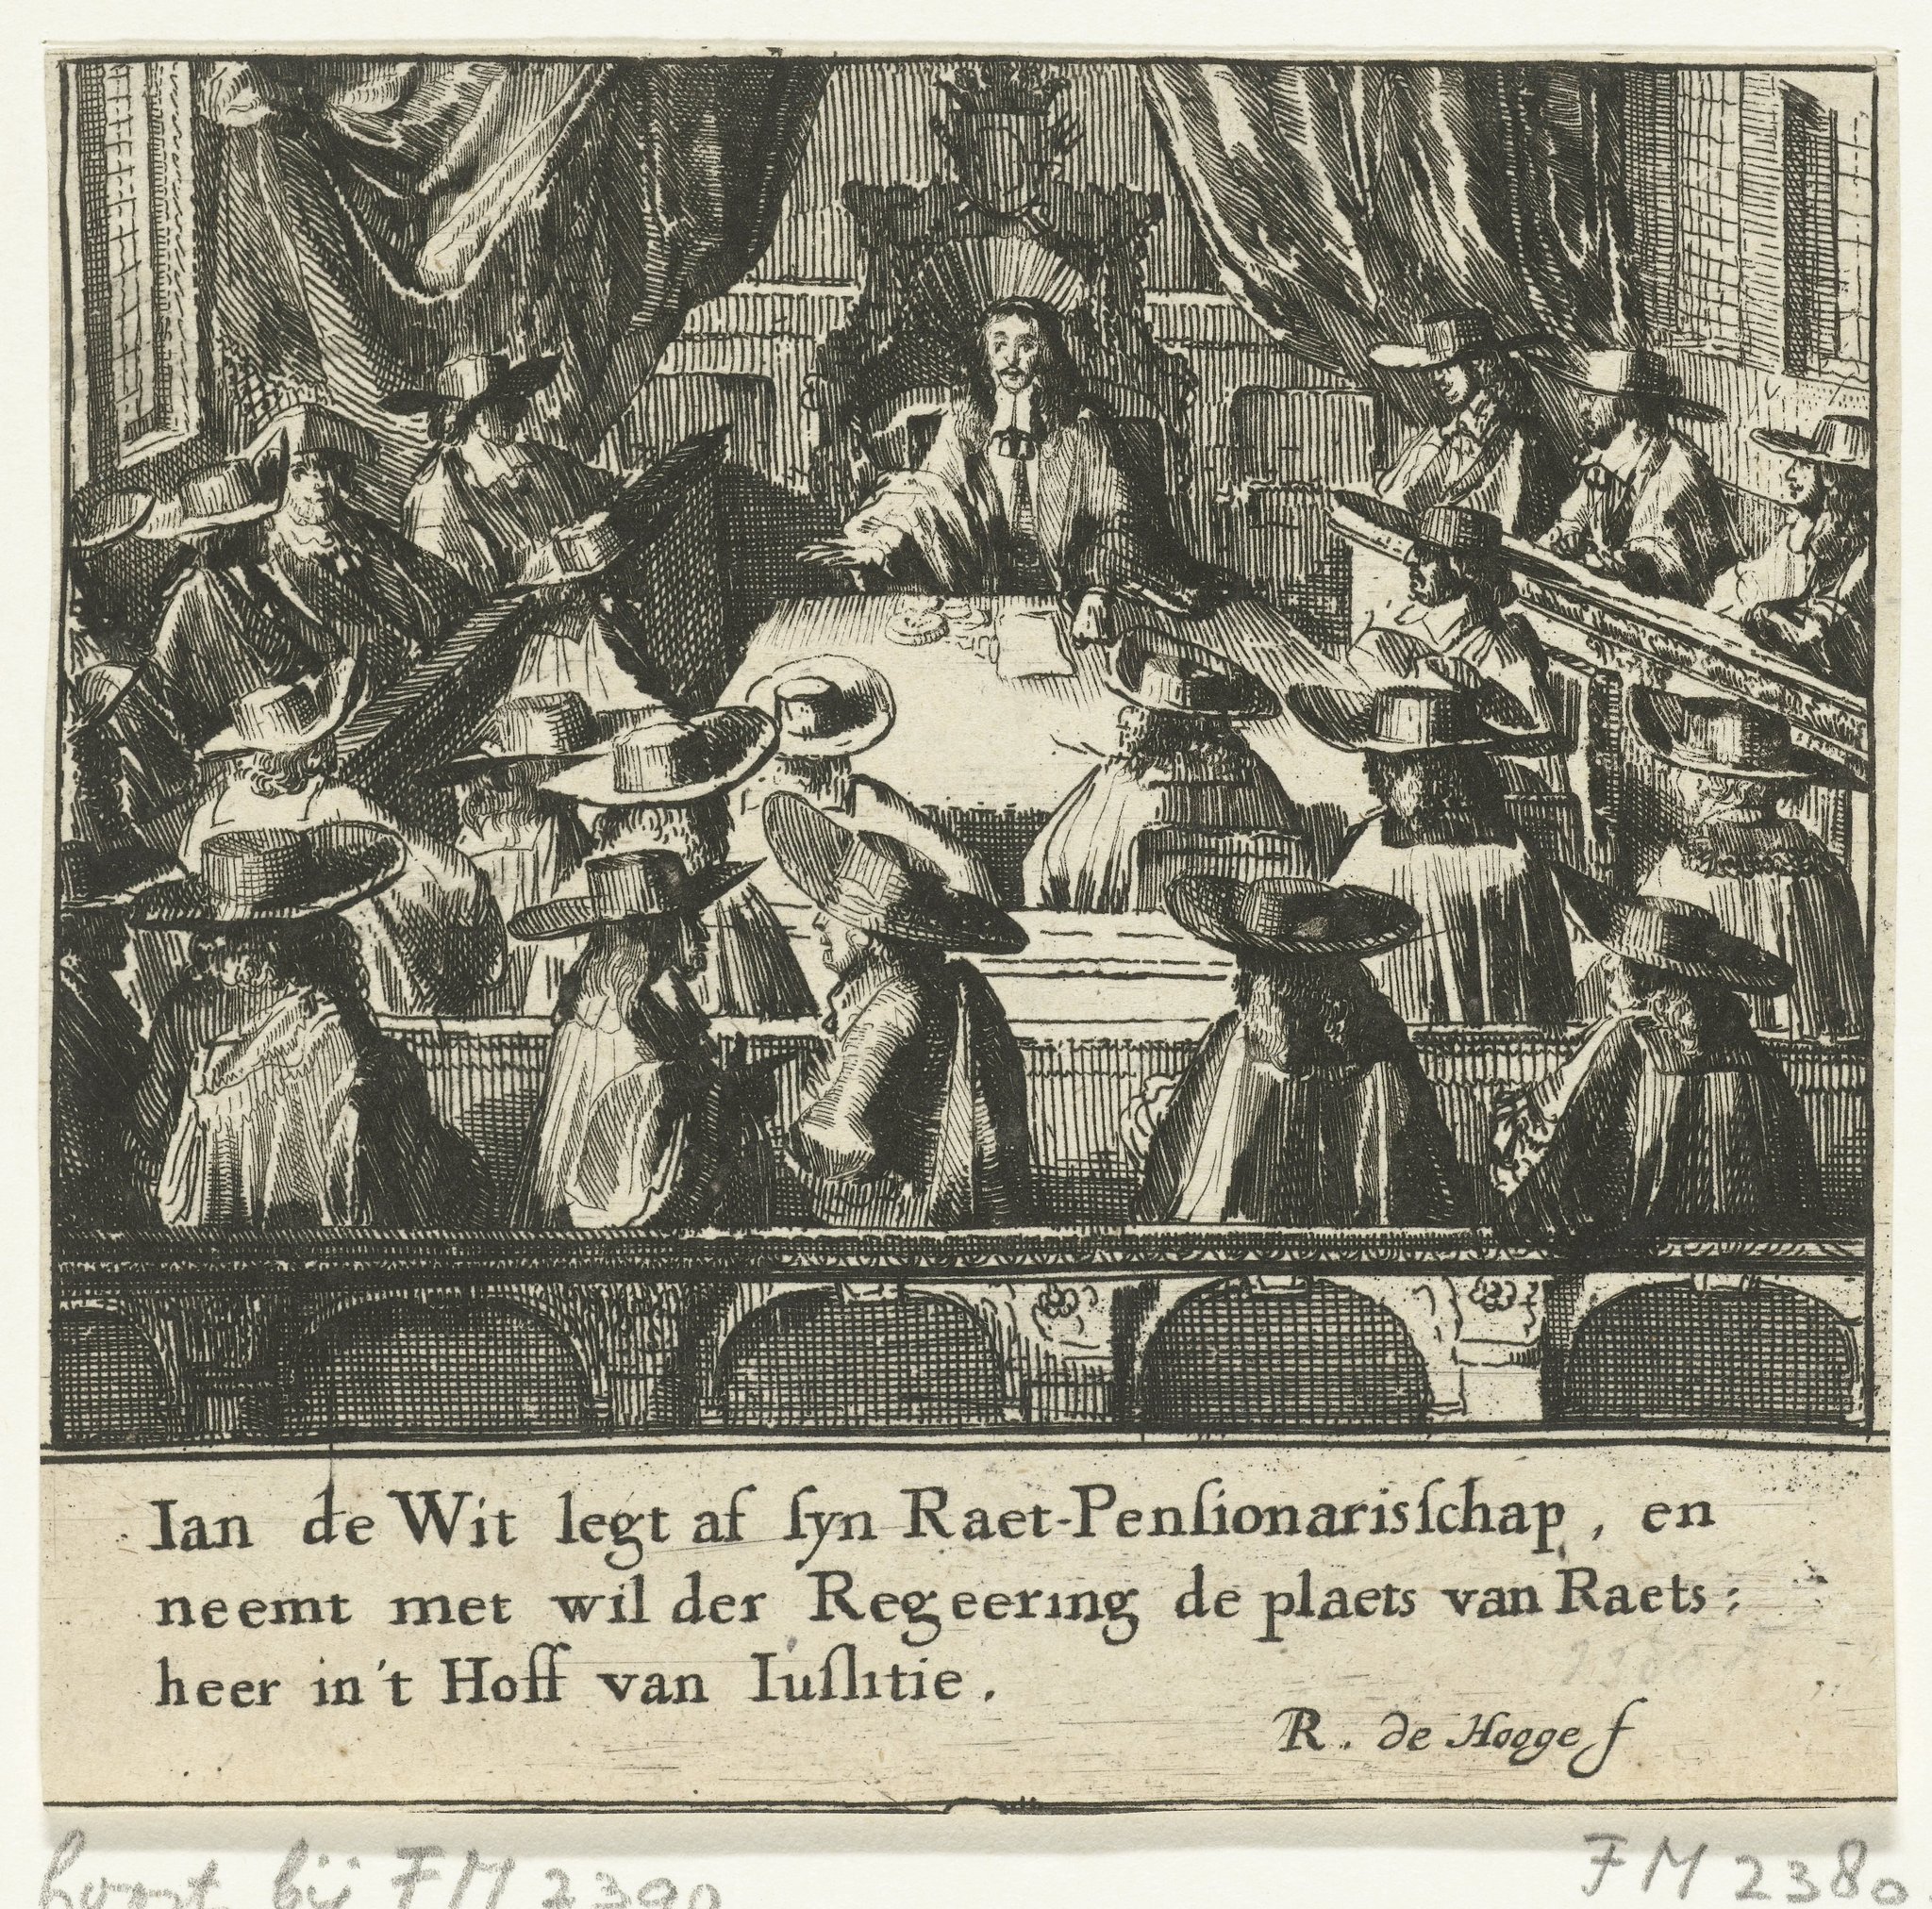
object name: history print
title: Johan de Witt doet afstand van zijn ambt als raadpensionaris, 1672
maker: romeyn de hooghe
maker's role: draughtsman, goldsmith, painter, print maker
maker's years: 1645-1708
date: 1675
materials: paper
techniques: etching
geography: northern netherlands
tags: politician, johan de witt, rampjaar (disaster year)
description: Johan de Witt doet afstand van zijn ambt als raadpensionaris en neemt plaats als raadsheer in het Hof van Justitie, 4 augustus 1672. Fragment van de grote prent over de gebroeders De Witt: Witten Wonder Spiegel (1675).